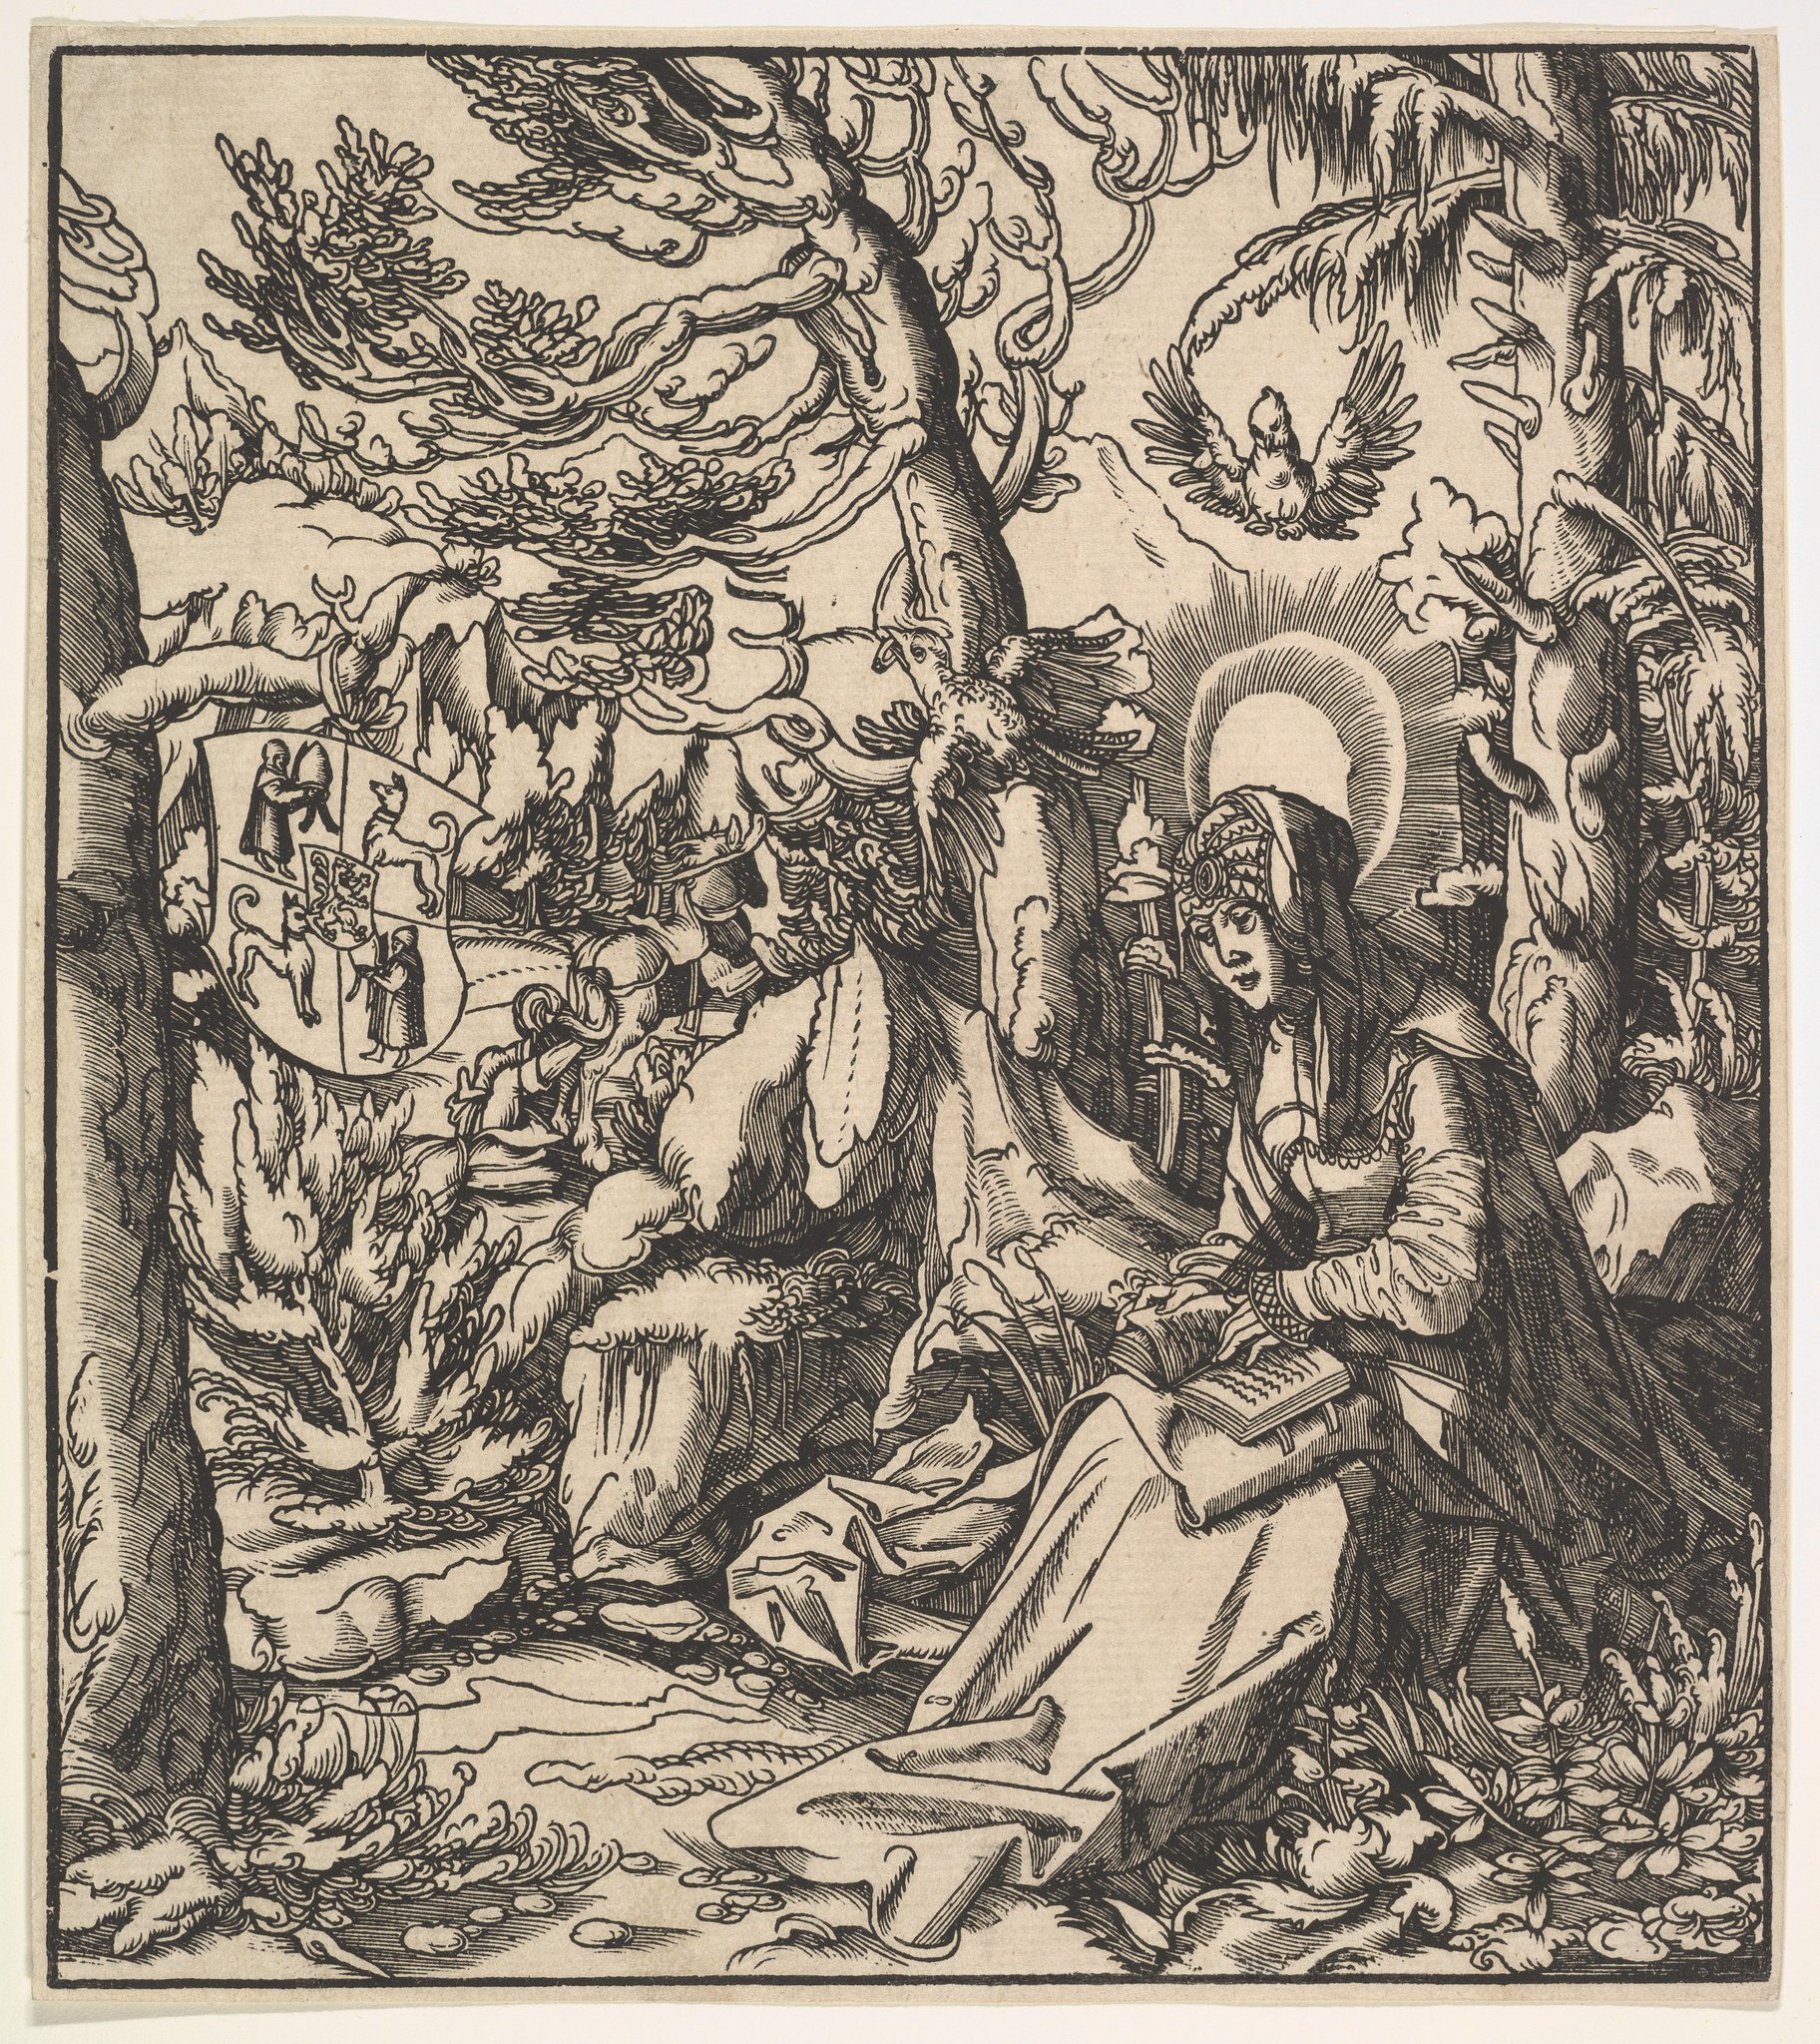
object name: print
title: Saint Ita (of Toggenburg), from "The Habsburg Saints"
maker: leonhard beck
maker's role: artist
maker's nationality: german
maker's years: 1480-1542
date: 1516-1518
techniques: woodcut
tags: birds,books,trees,saints,insignia